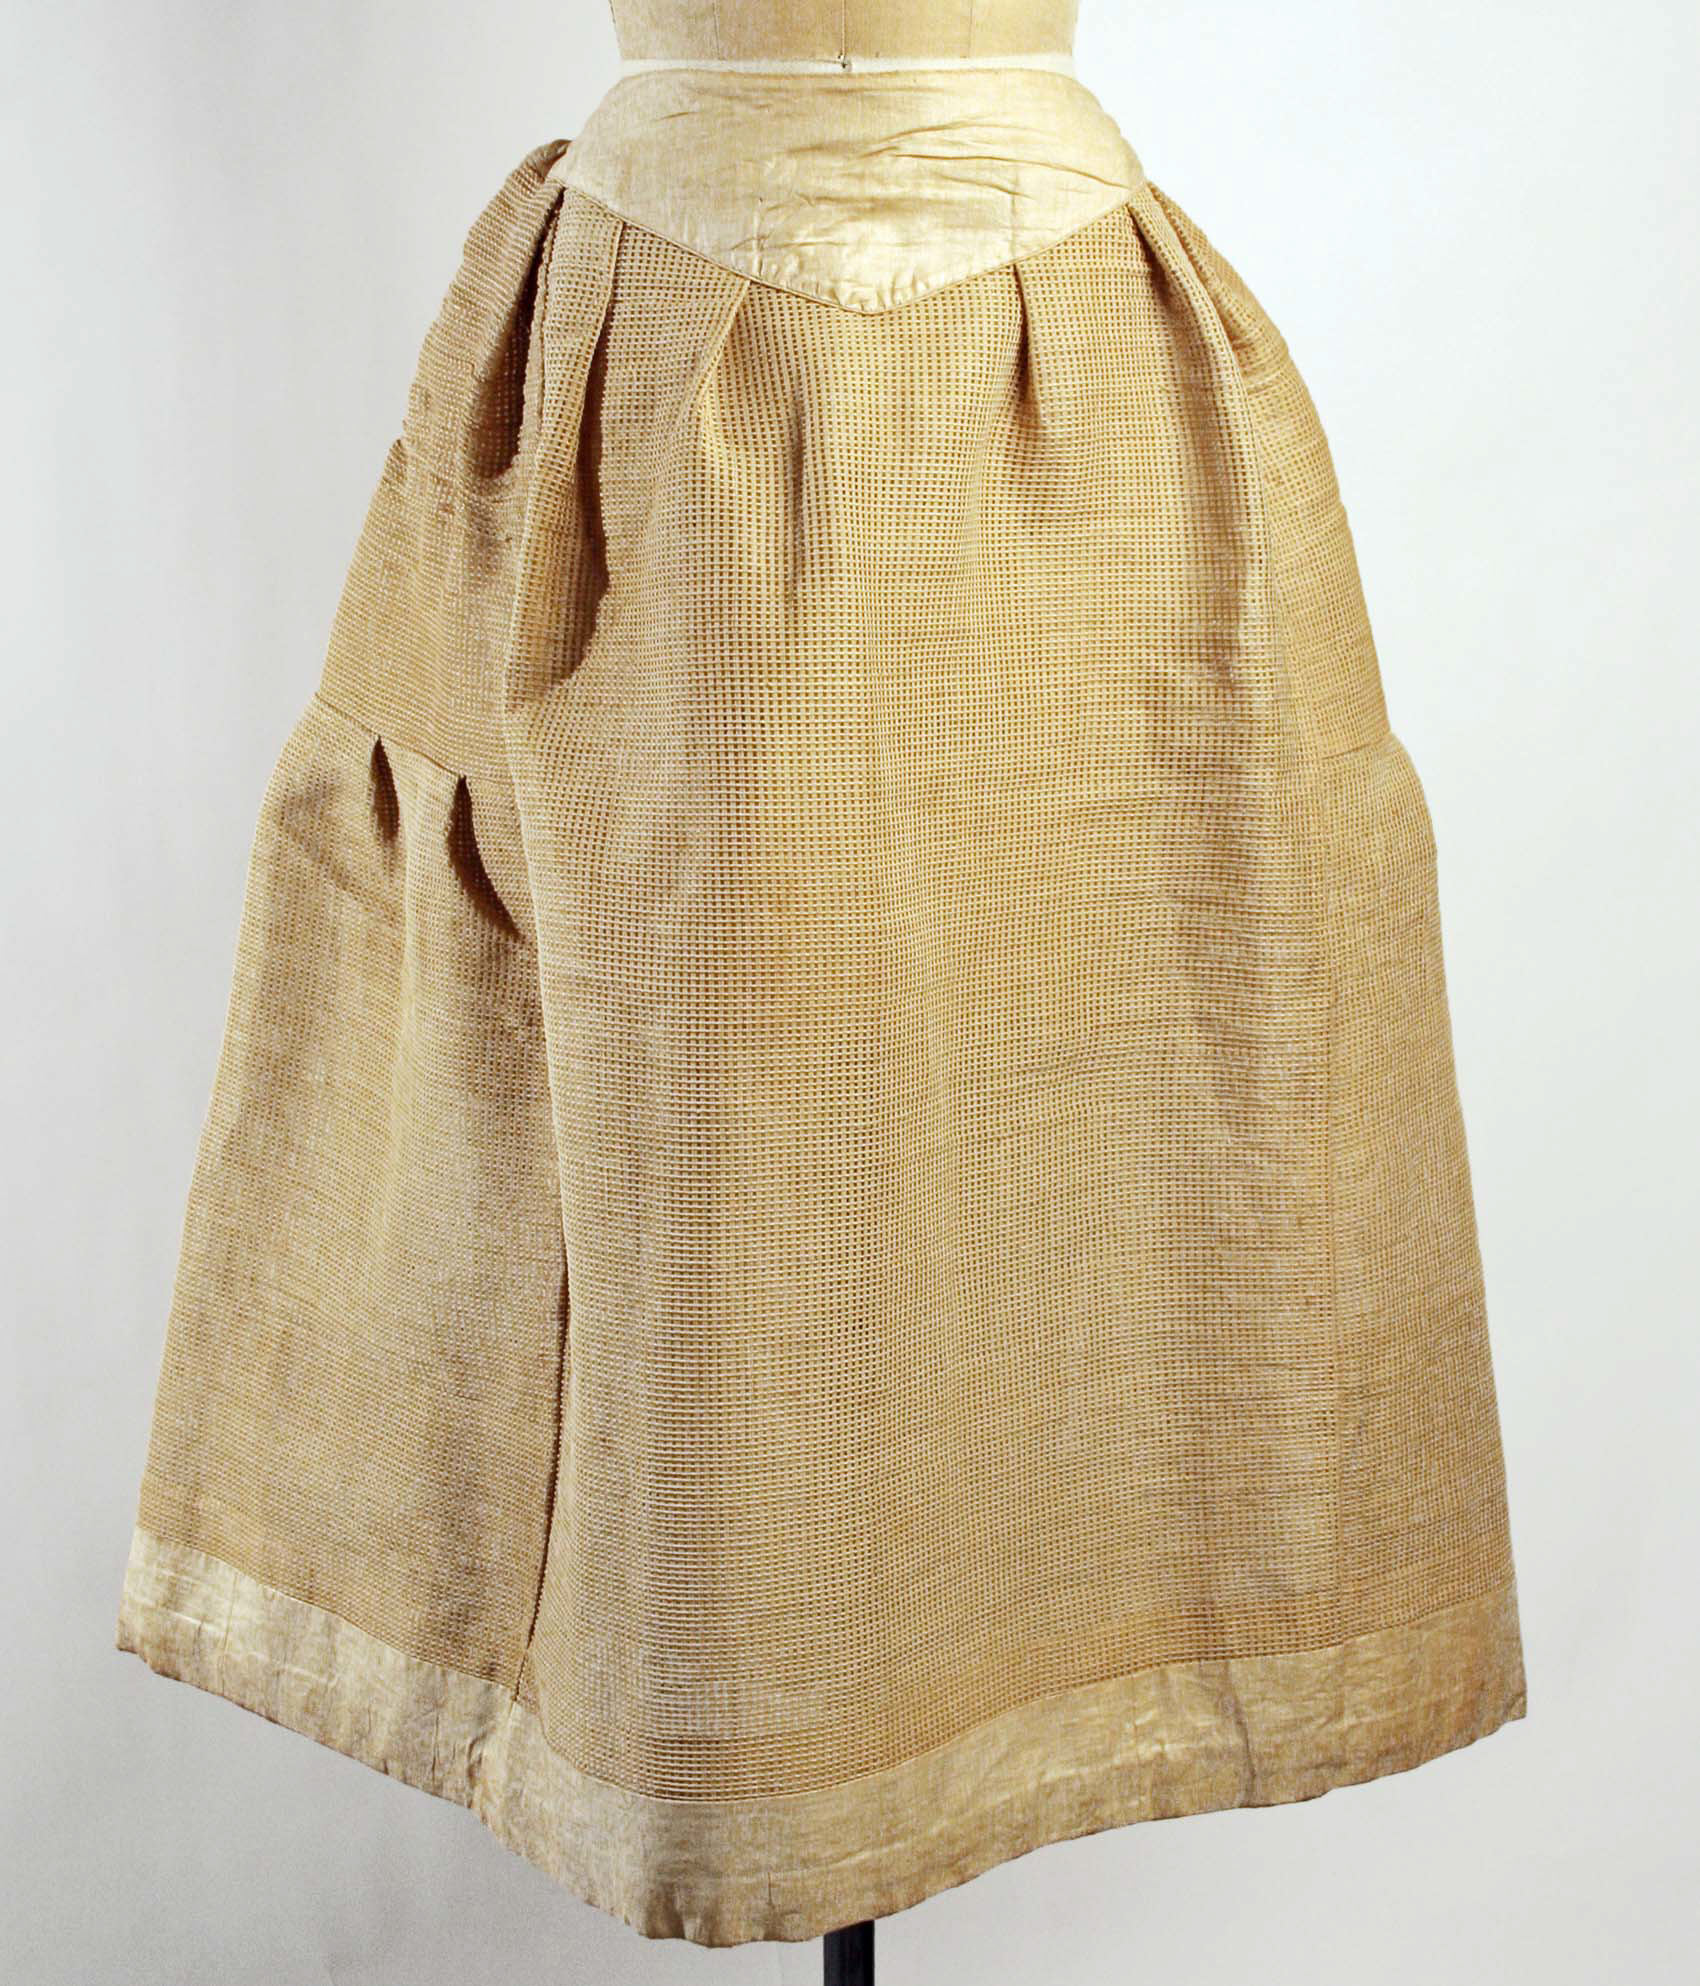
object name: petticoat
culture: american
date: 1870-1879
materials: cotton, hair